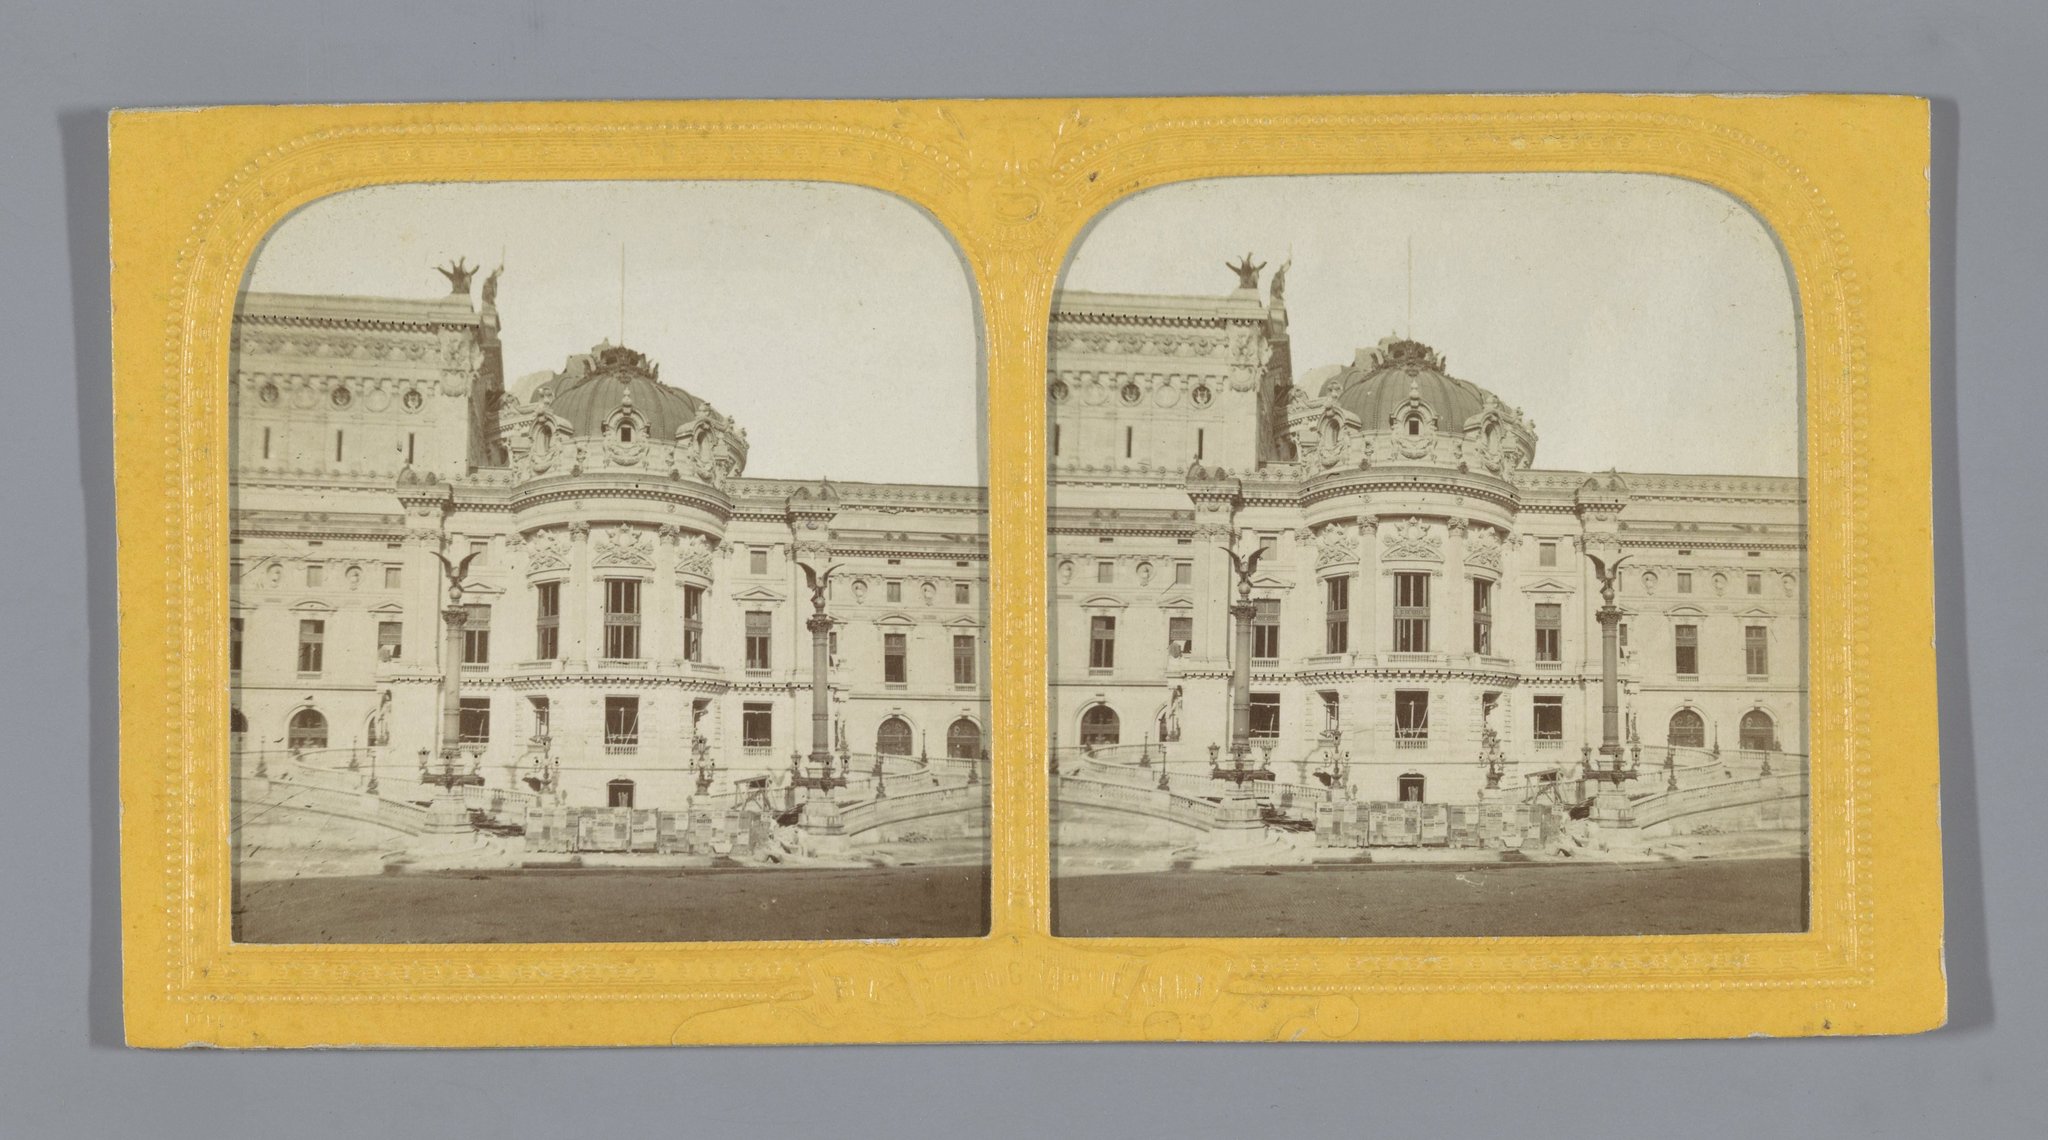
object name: tissue stereograph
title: Westfaçade van de Opéra Garnier, Parijs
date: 1874-1875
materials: cardboard, paper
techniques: albumen print, hand coloring, perforating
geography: paris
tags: opera house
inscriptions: inscription: ‘Déposé’